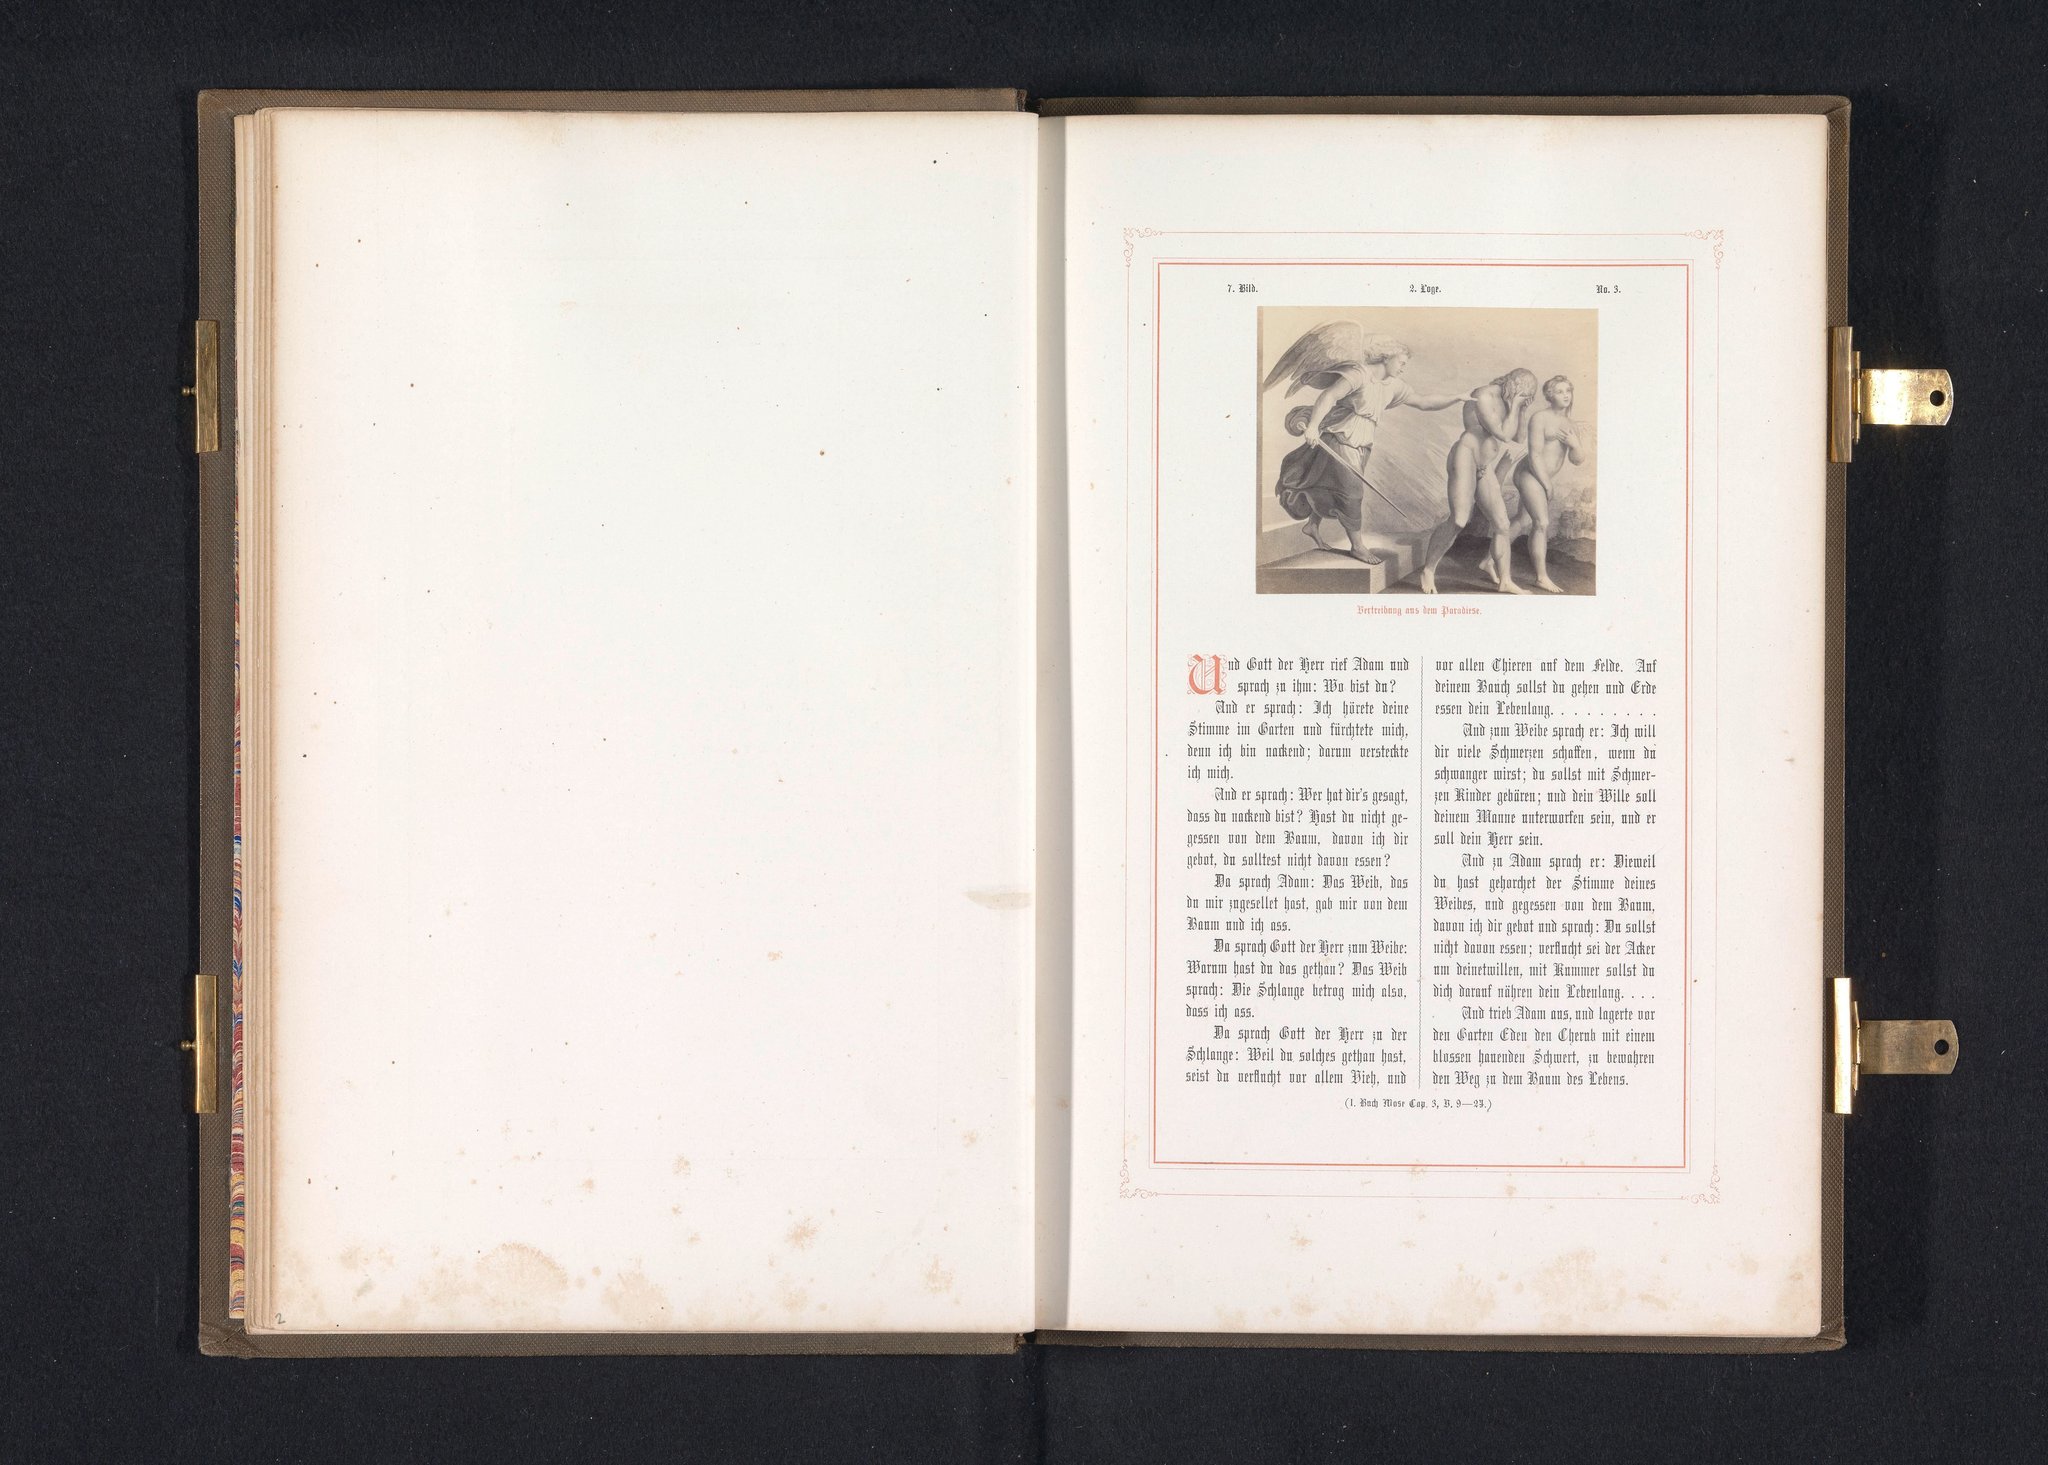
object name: reproduction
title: Fotoreproductie van een prent naar een fresco van de verdrijving uit het paradijs van Adam en Eva door Rafaël voor de loggia's in het Vaticaan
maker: gustav schauer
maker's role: painter, publisher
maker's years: 1826-1902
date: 1851-1861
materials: photographic support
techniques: albumen print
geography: berlin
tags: expulsion of adam and eve from paradise (genesis 3:22-24)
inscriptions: inscription: ‘7. Bild. 2. Loge. No.3.’